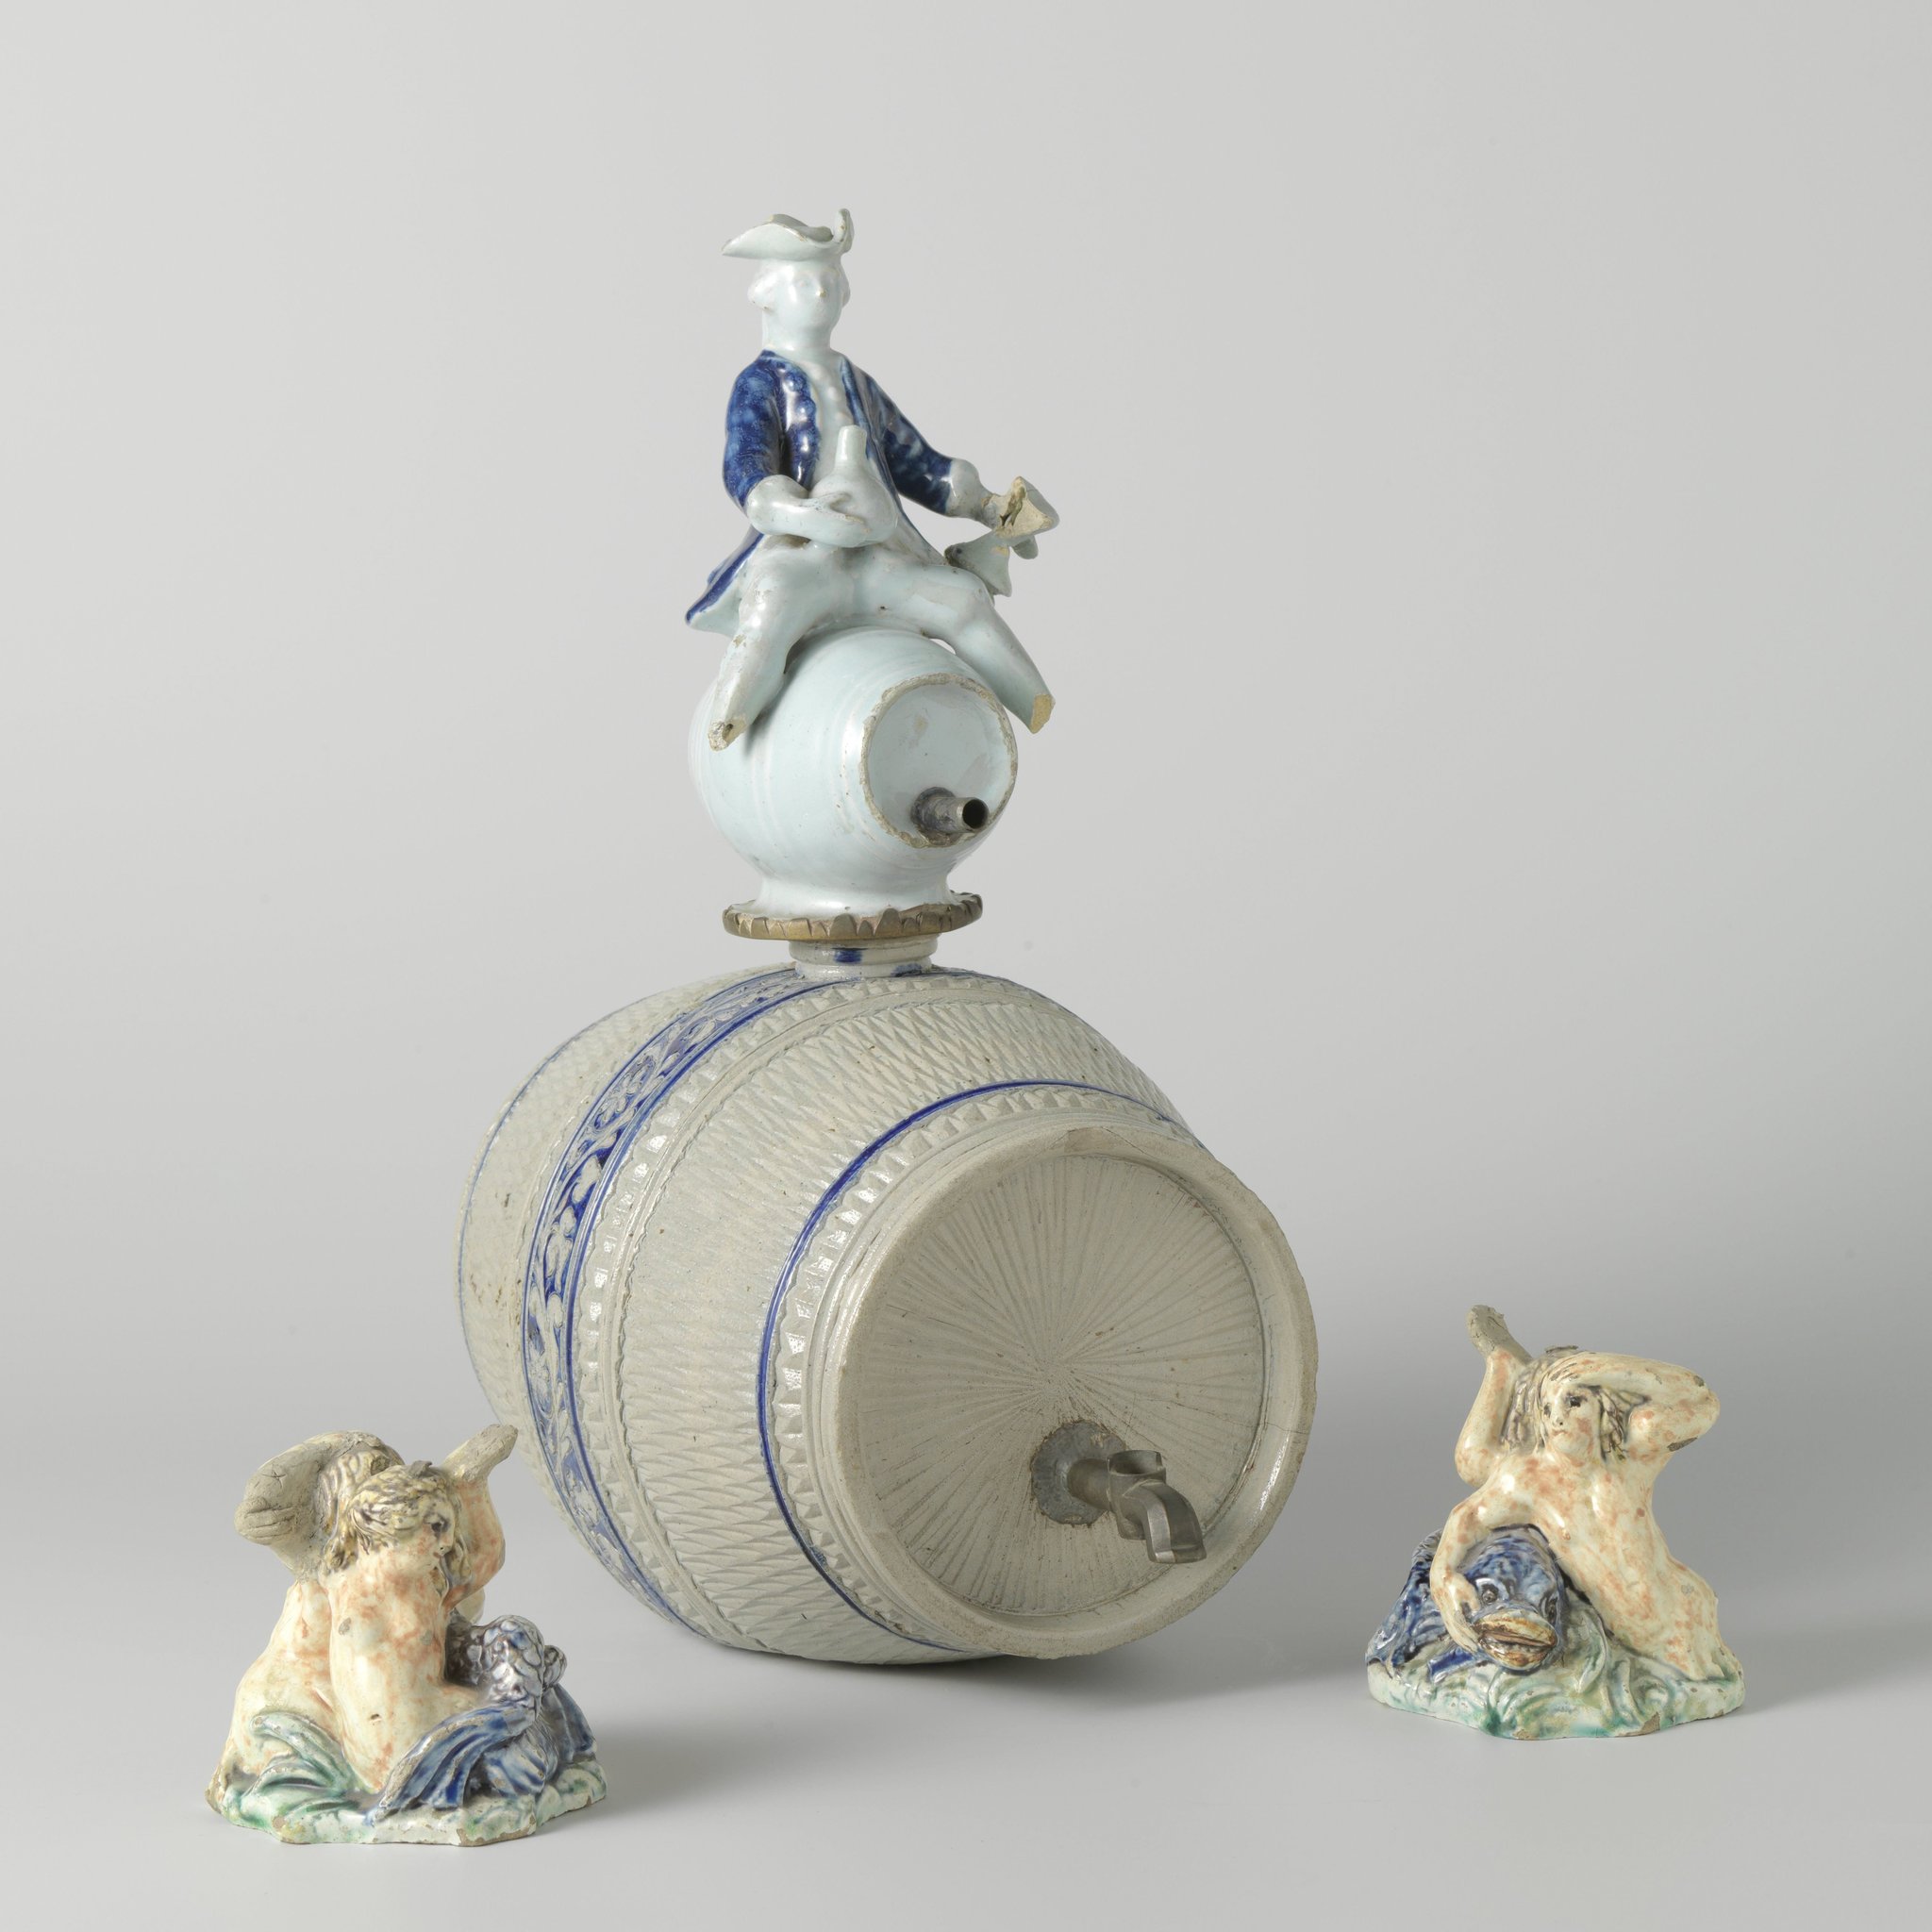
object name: vessel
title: Vat met drinkebroer, behorend bij meiwijnvat van steengoed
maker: Anonymous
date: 1740-1760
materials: brass, cork, earthenware, glaze, tin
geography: delft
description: Drinkebroer, behorend bij meiwijnvat van steengoed met tinnen tap.